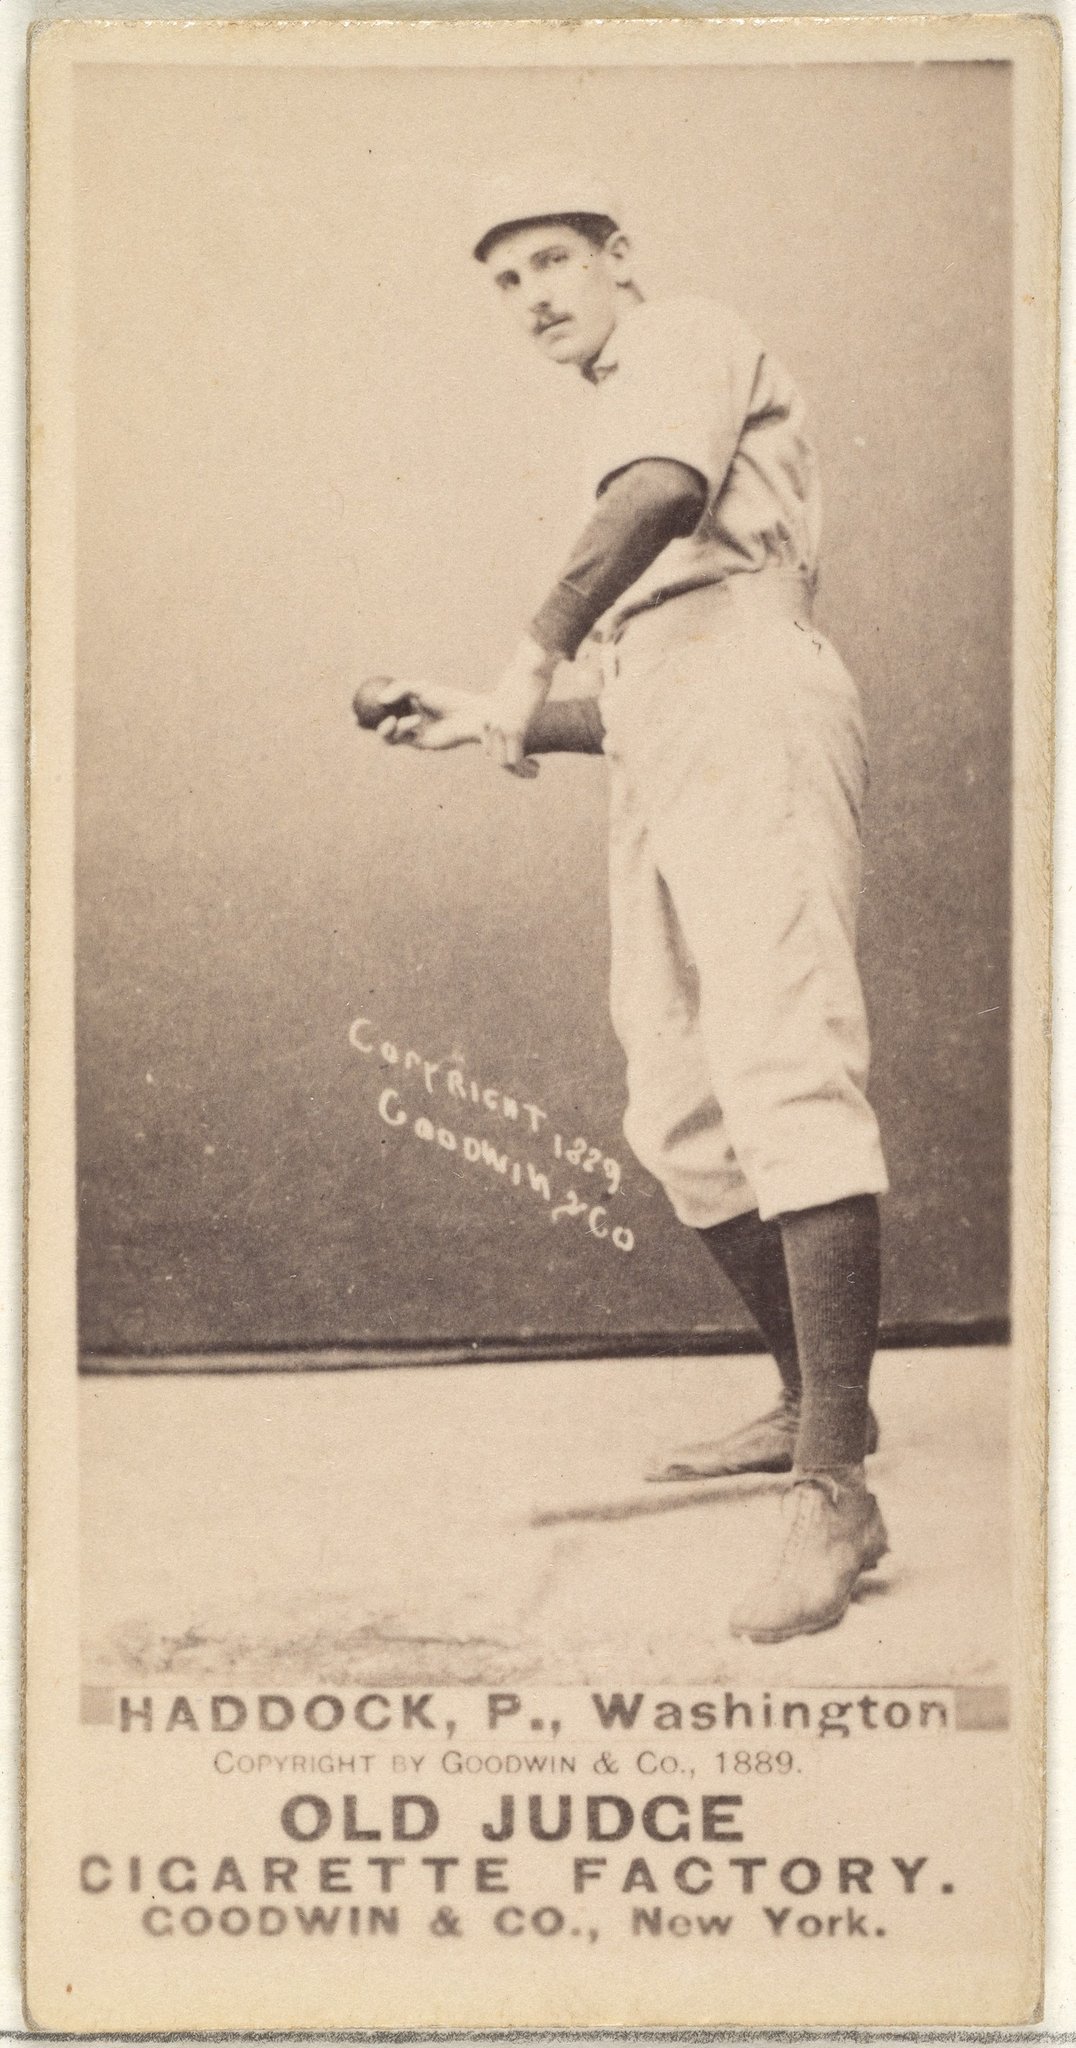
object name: baseball card, photograph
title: George Silas Haddock, Pitcher, Washington Nationals, from the Old Judge series (N172) for Old Judge Cigarettes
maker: goodwin & company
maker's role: publisher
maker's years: 1850-1950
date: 1889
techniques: albumen silver print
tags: men,portraits,baseball,athletes